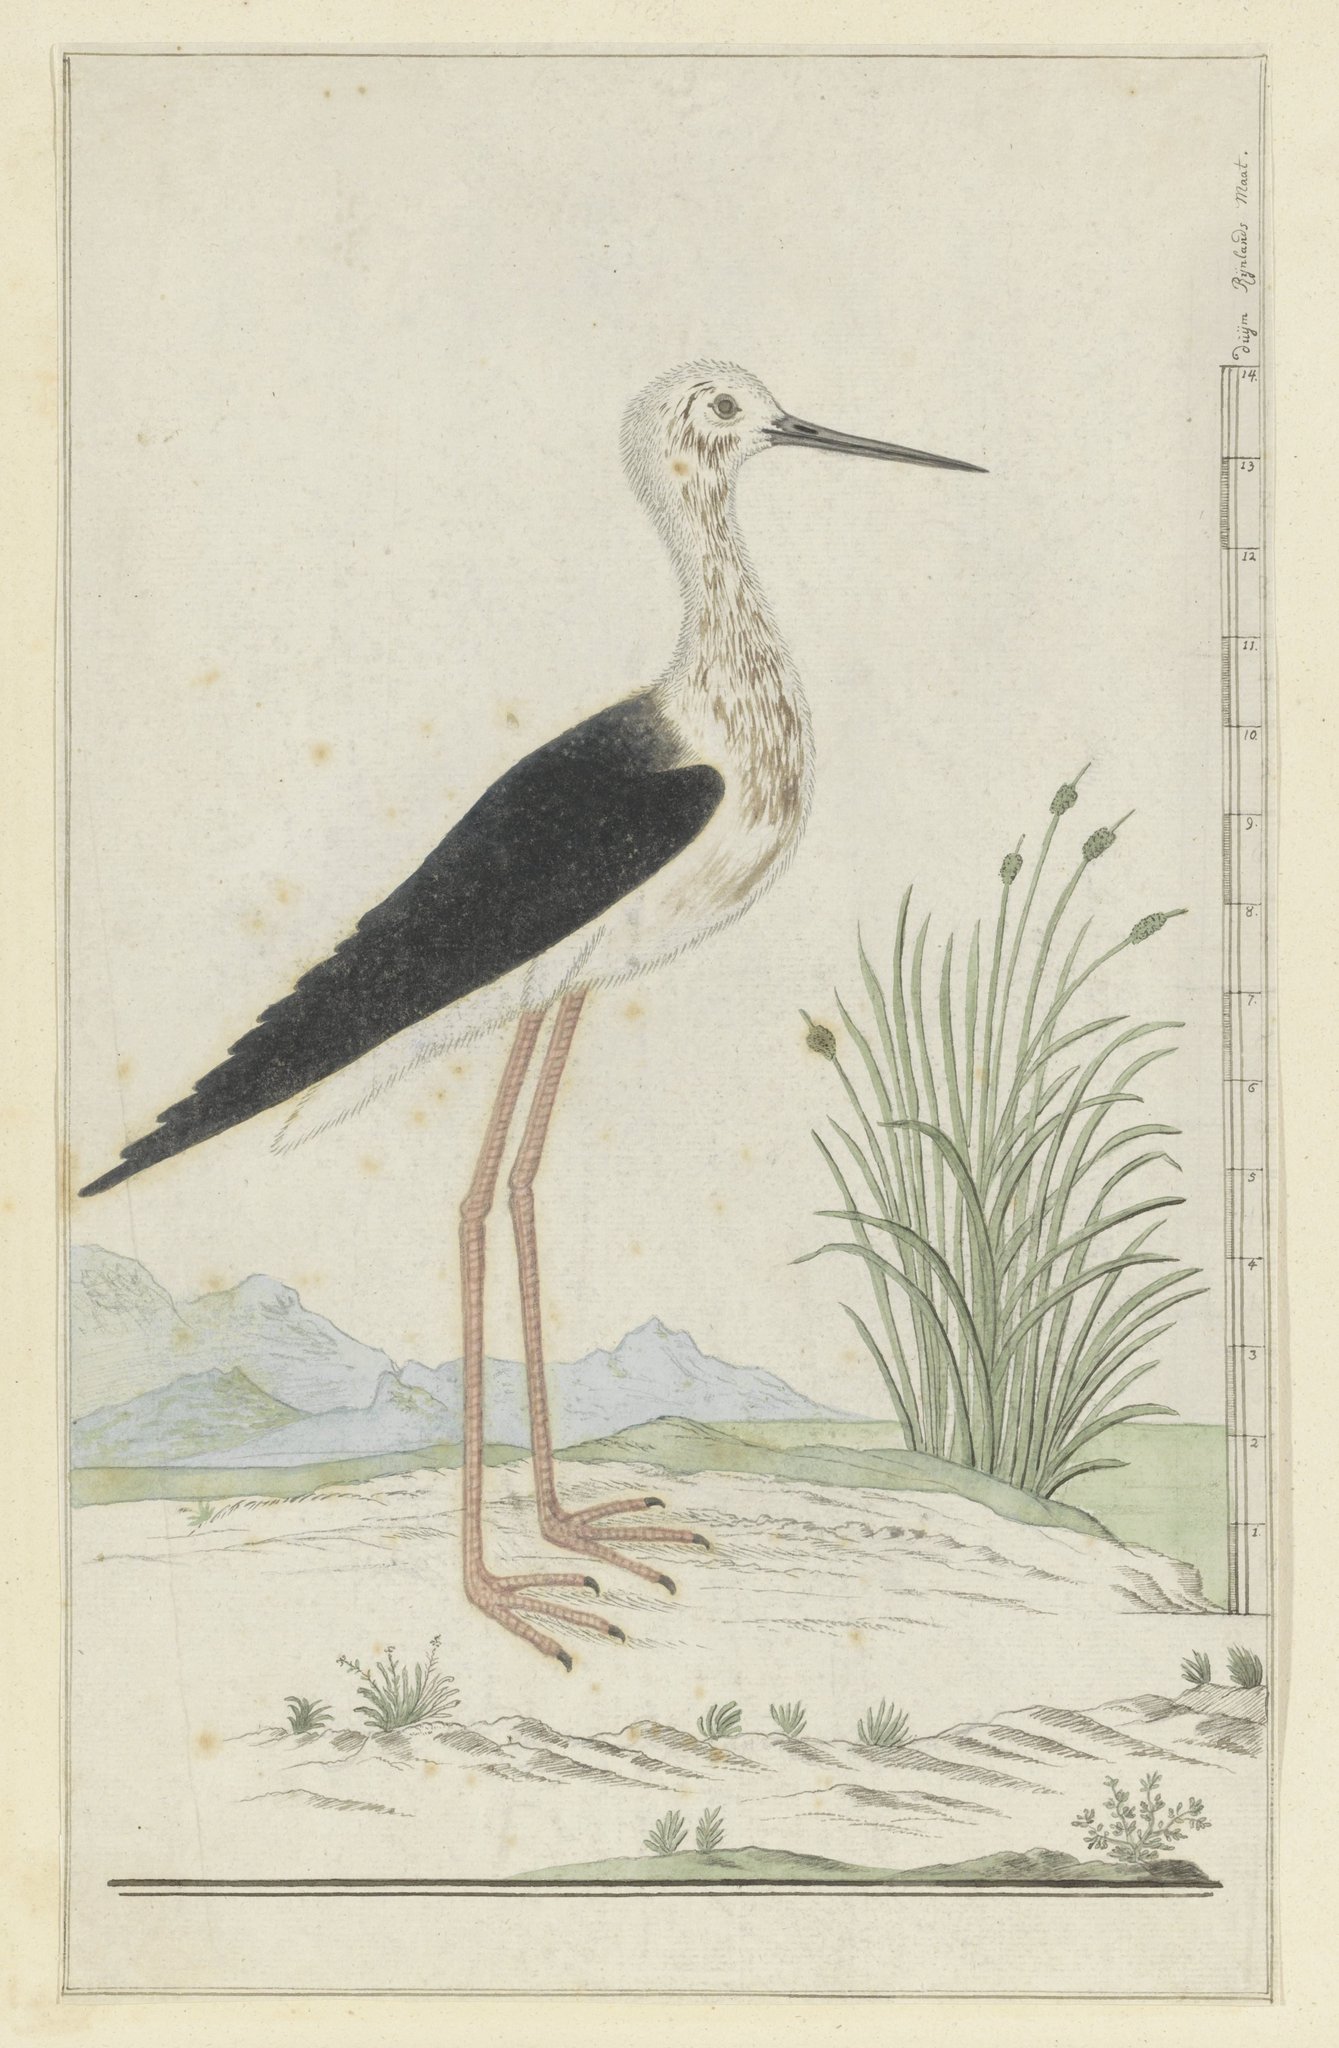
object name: album leaf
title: Himantopus himantopus (Black-winged stilt)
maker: robert jacob gordon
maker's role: draughtsman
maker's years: 1743-1795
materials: chalk, ink, paper, pencil, watercolor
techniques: brush, pen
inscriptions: annotation: ‘schaalverdeling met: duijm Rijnlands Maat.’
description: Vogelstudie: Steltkluut (Himantopus himantopus); met schaalverdeling in Rijnlandse maat.